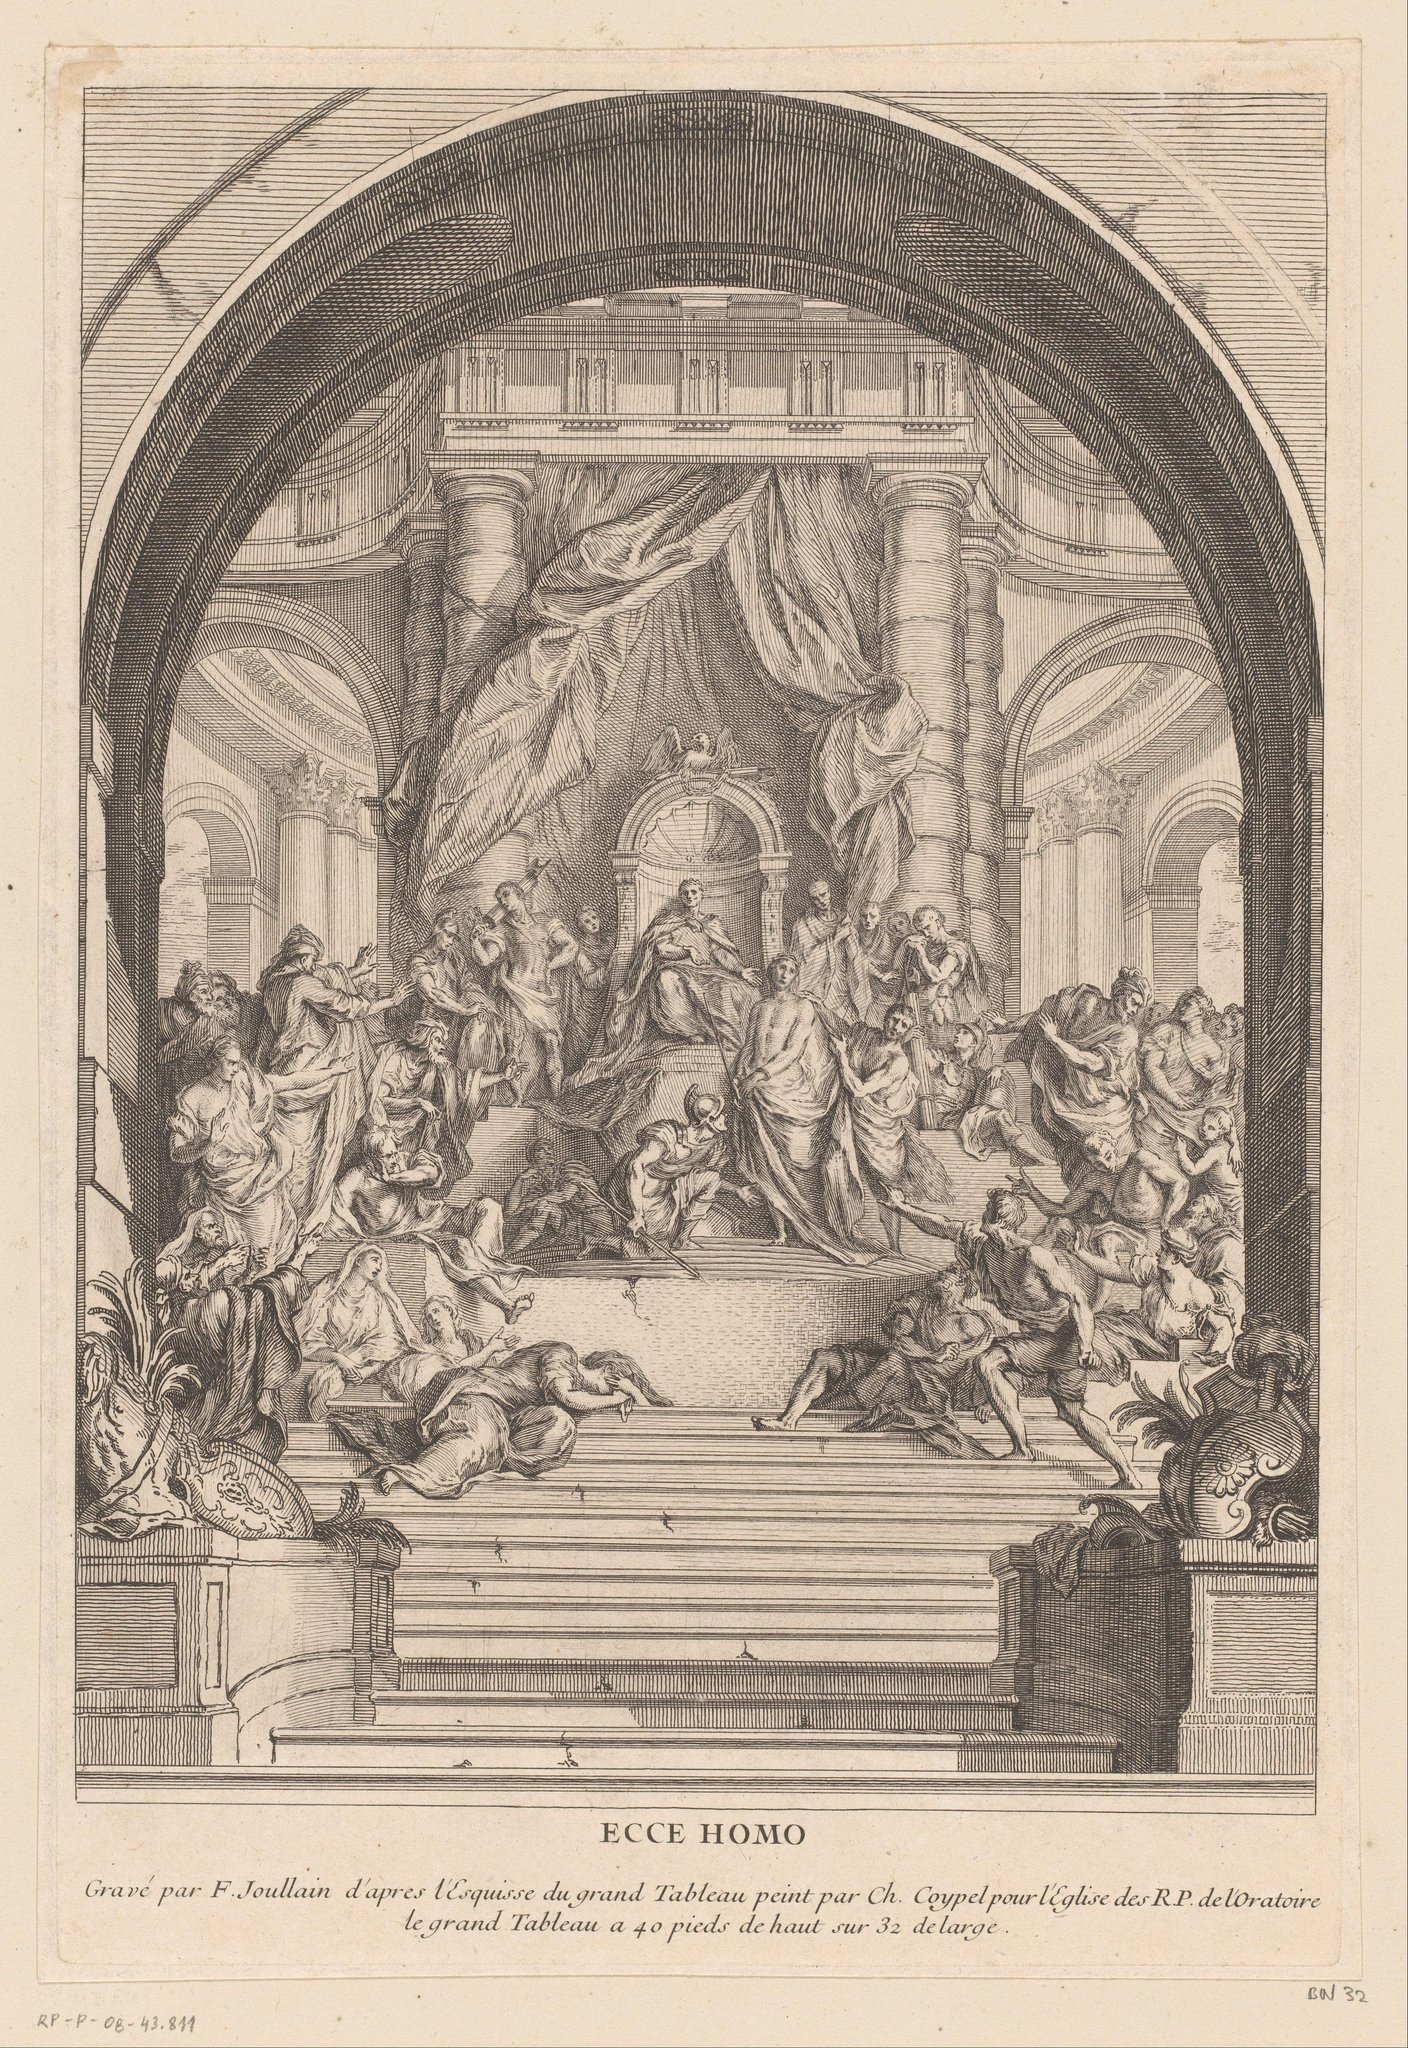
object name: print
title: Ecce Homo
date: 1729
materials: paper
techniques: engraving, etching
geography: france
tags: christ alone (also called 'ecce homo')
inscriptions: collector's mark: Lugt 240